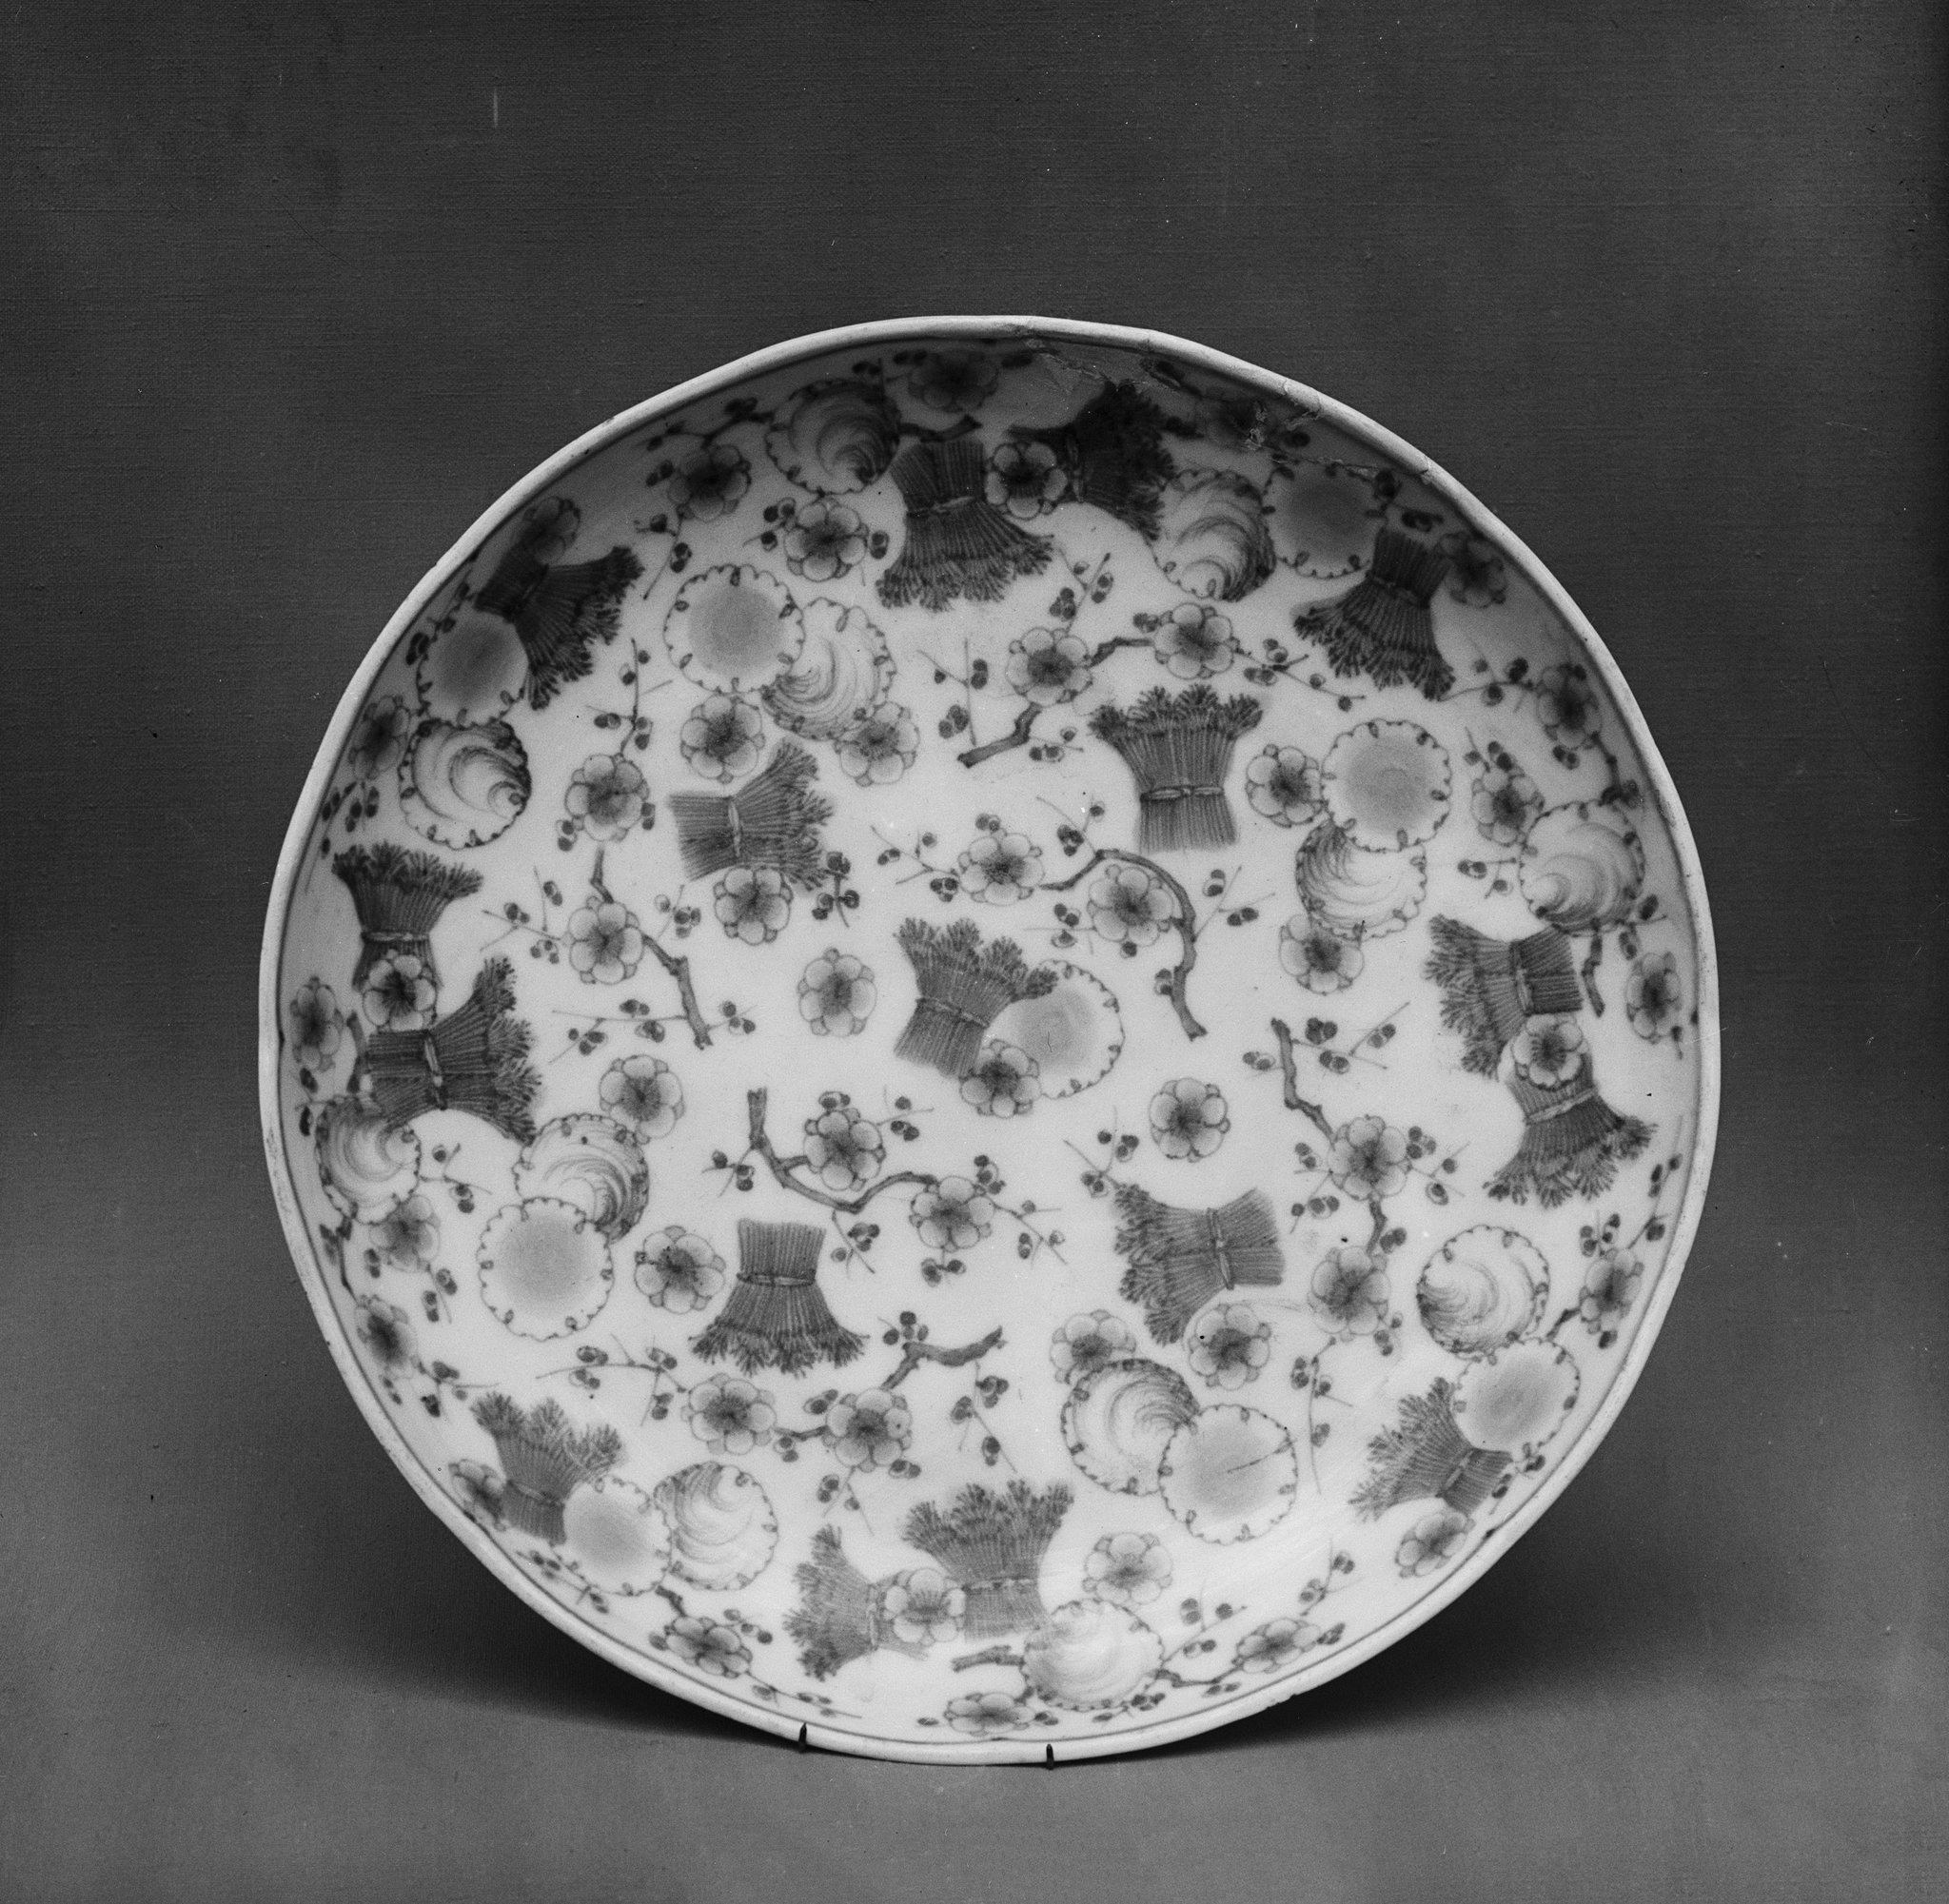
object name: dish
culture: japanese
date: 1750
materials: glaze, porcelain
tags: flowers